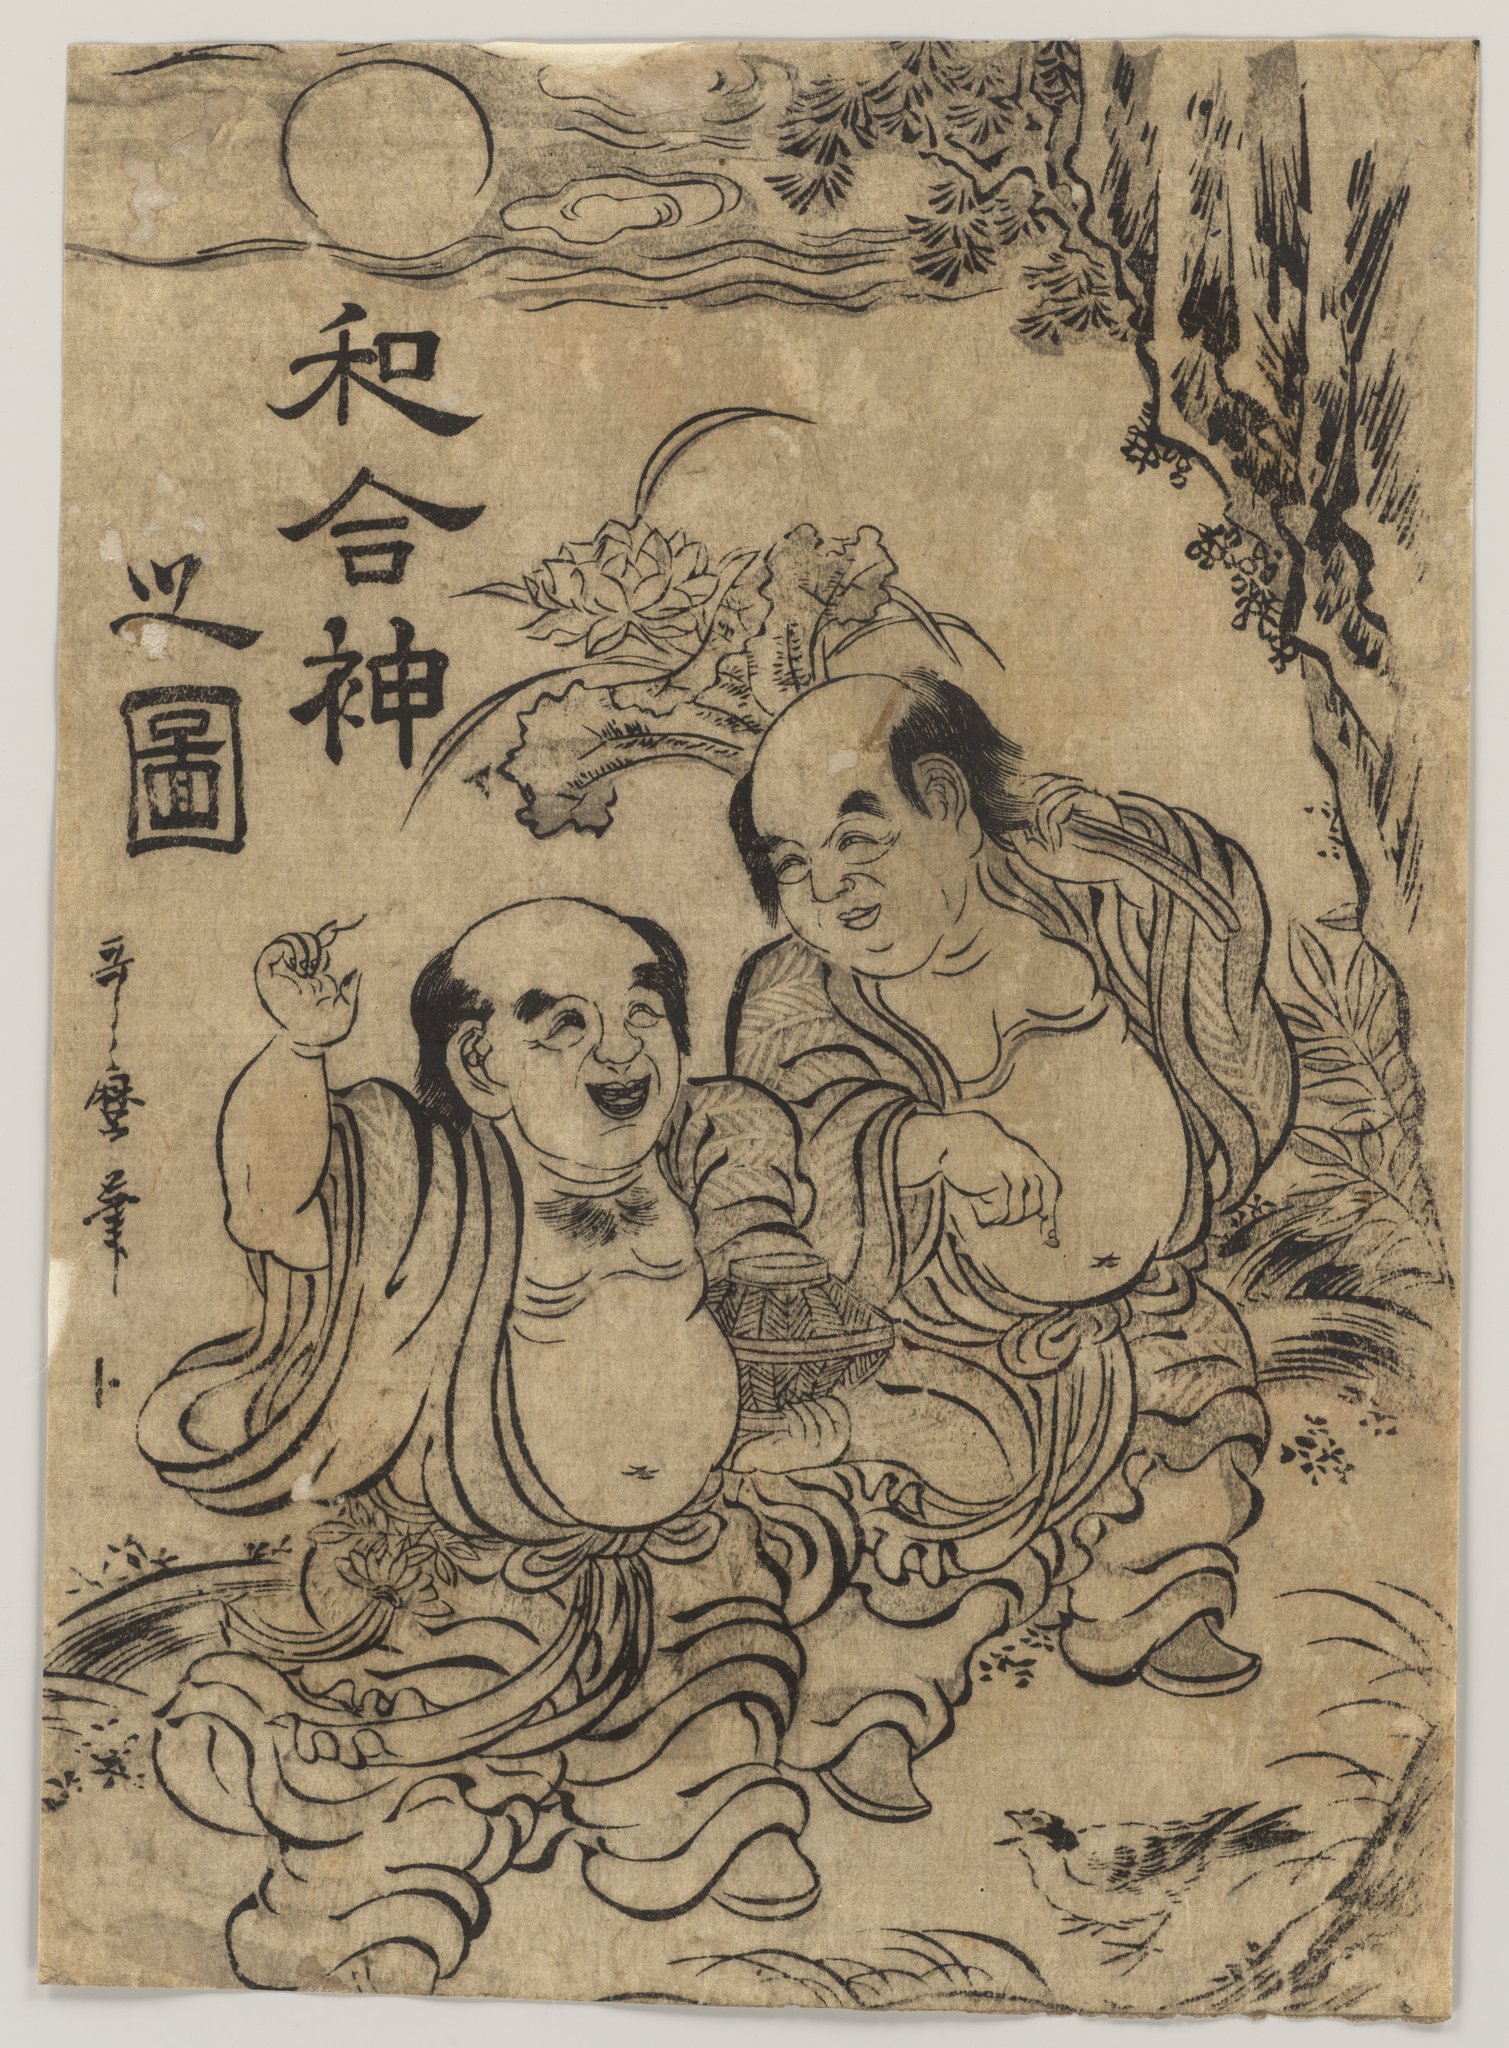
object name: print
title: The Two Immortals of Harmony and Unity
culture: japanese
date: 1734-1766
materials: ink, paper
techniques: woodblock print